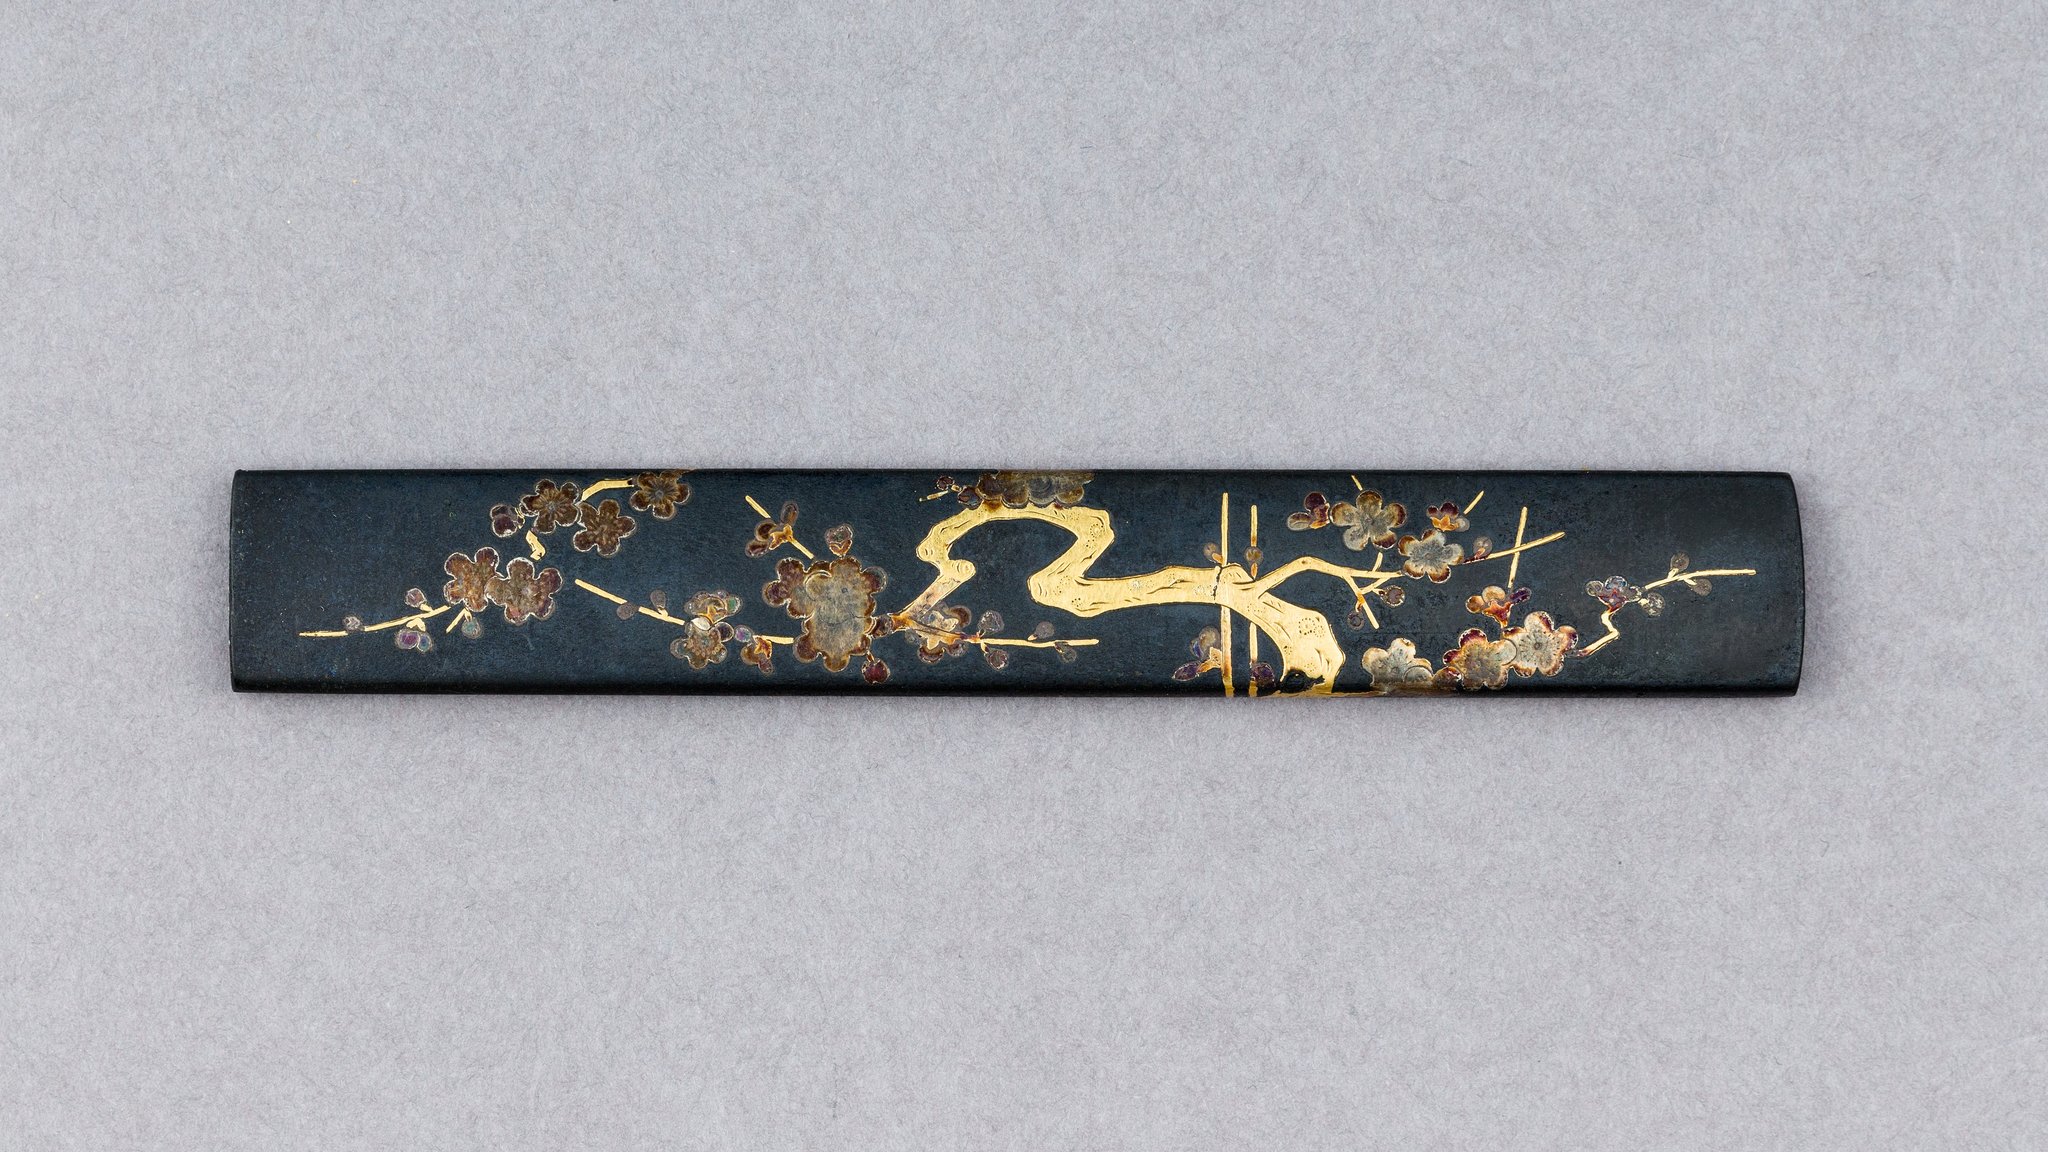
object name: knife handle kozuka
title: Knife Handle (Kozuka)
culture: japanese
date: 1615-1868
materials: gold alloy, silver alloy, gold, silver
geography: japan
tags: flowers